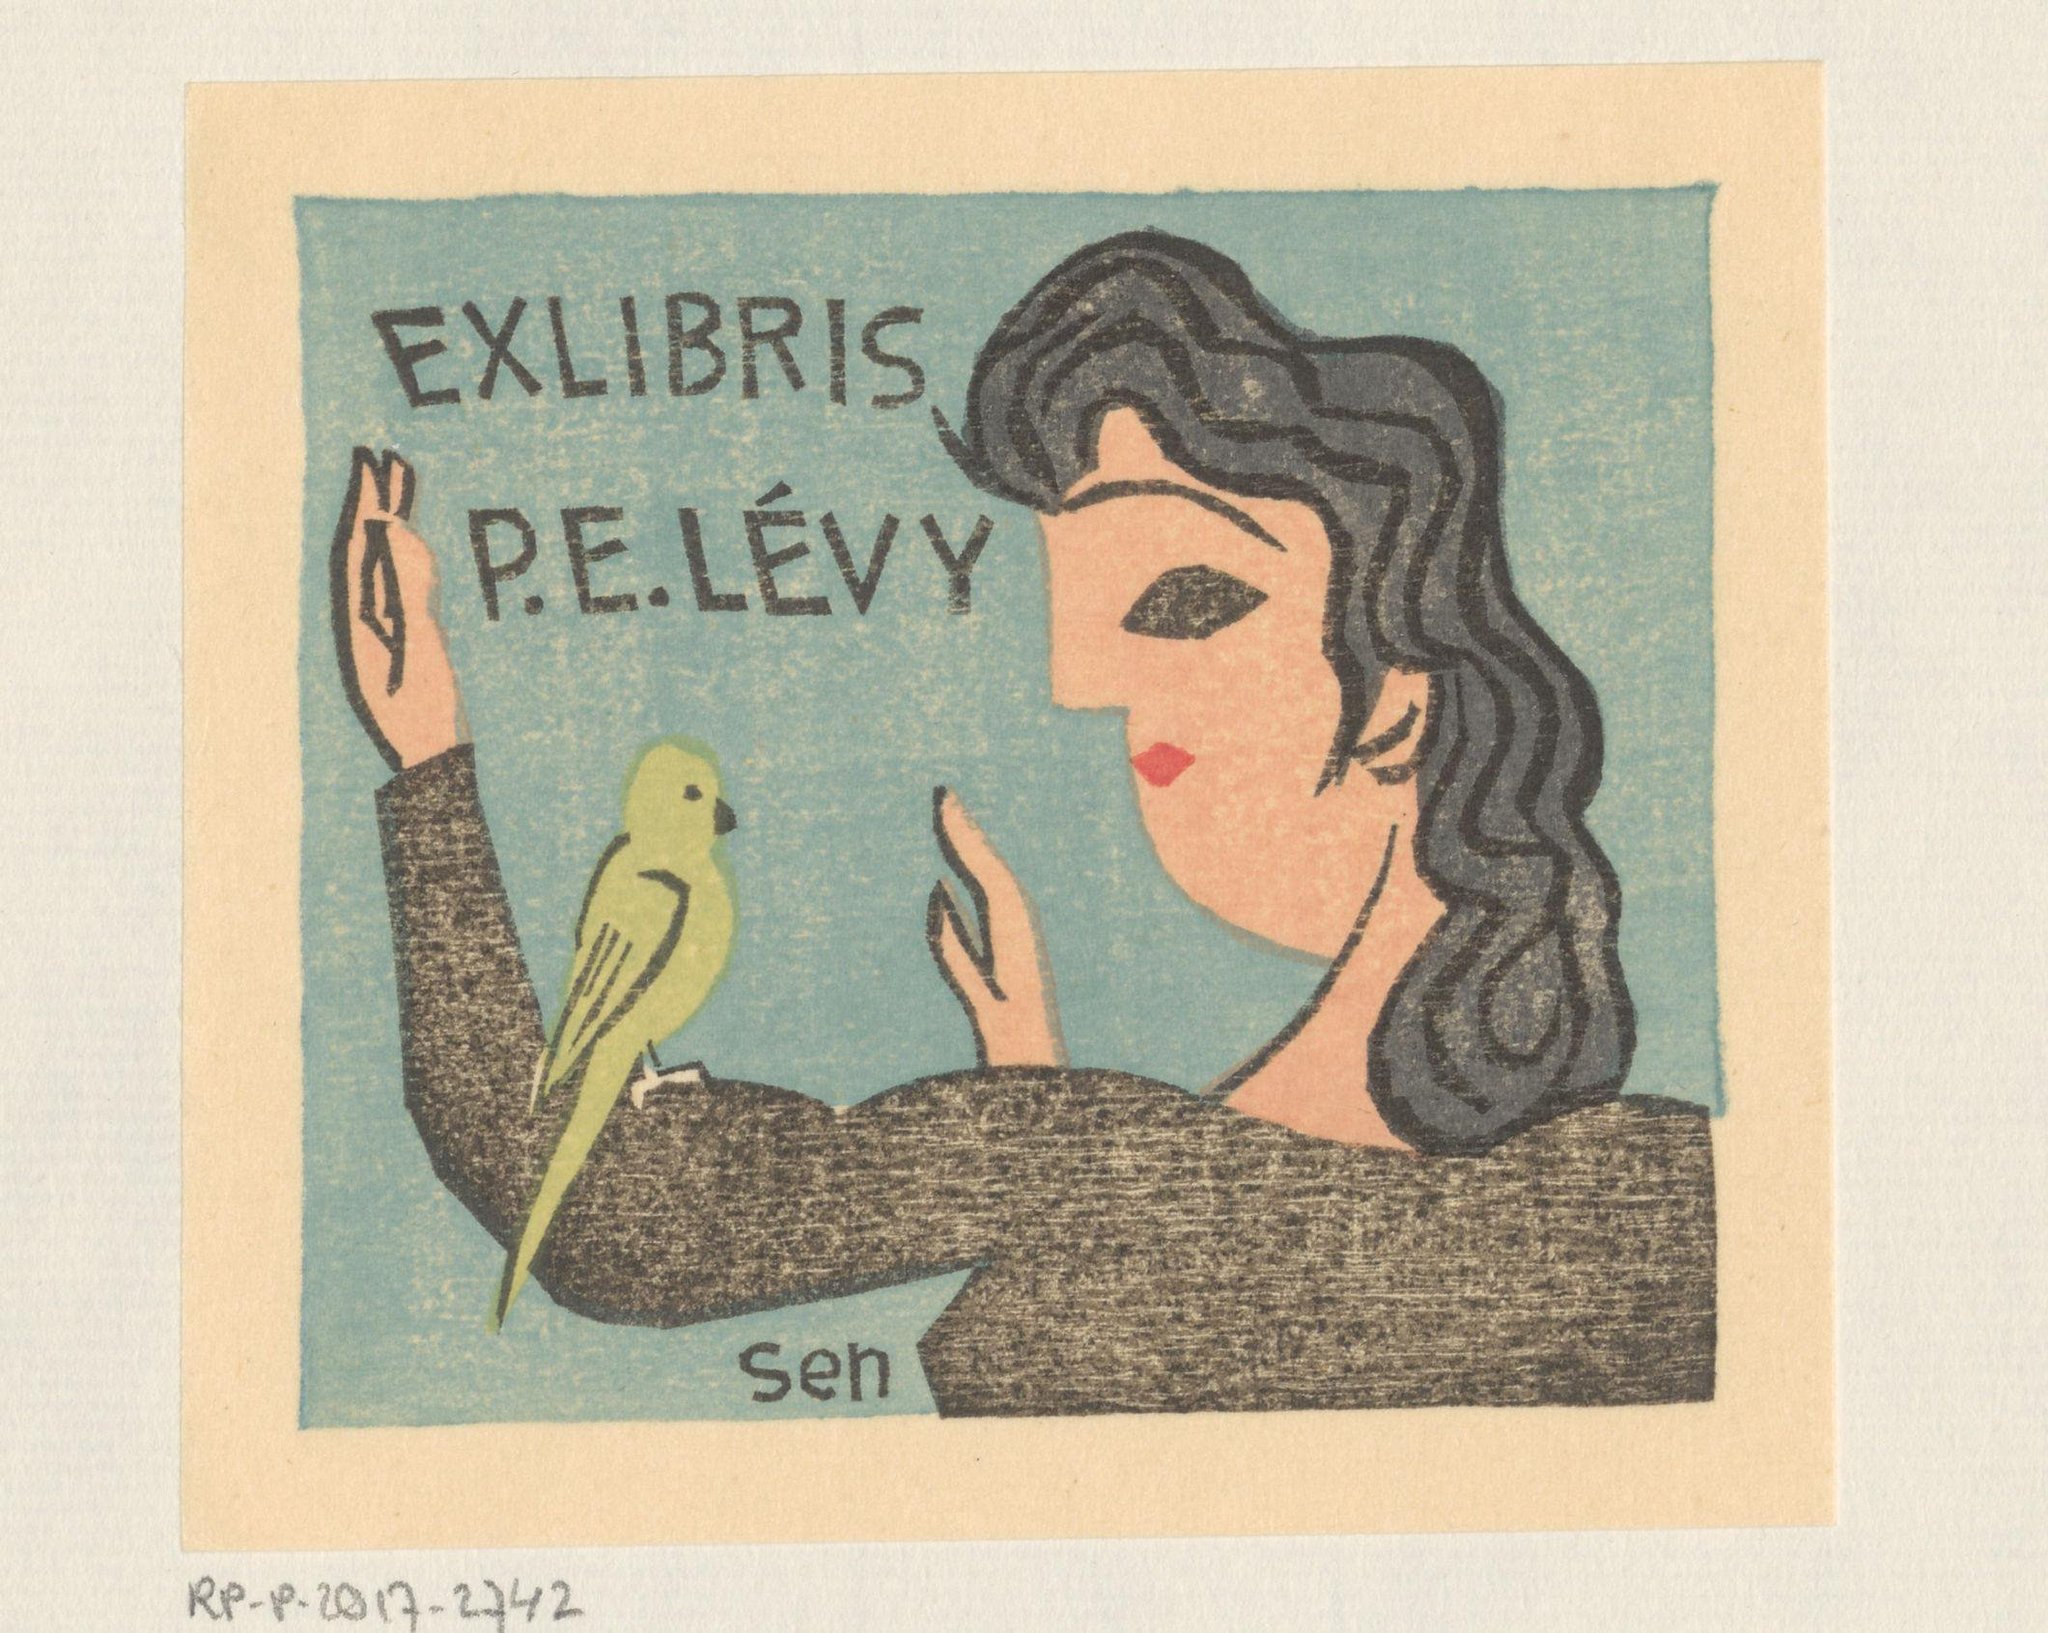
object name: bookplate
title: Ex libris van P.E. Lévy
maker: Anonymous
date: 1900-1999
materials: paper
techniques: woodcut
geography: japan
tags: ornamental birds: parrot, head turned sideways - aa - female human figure